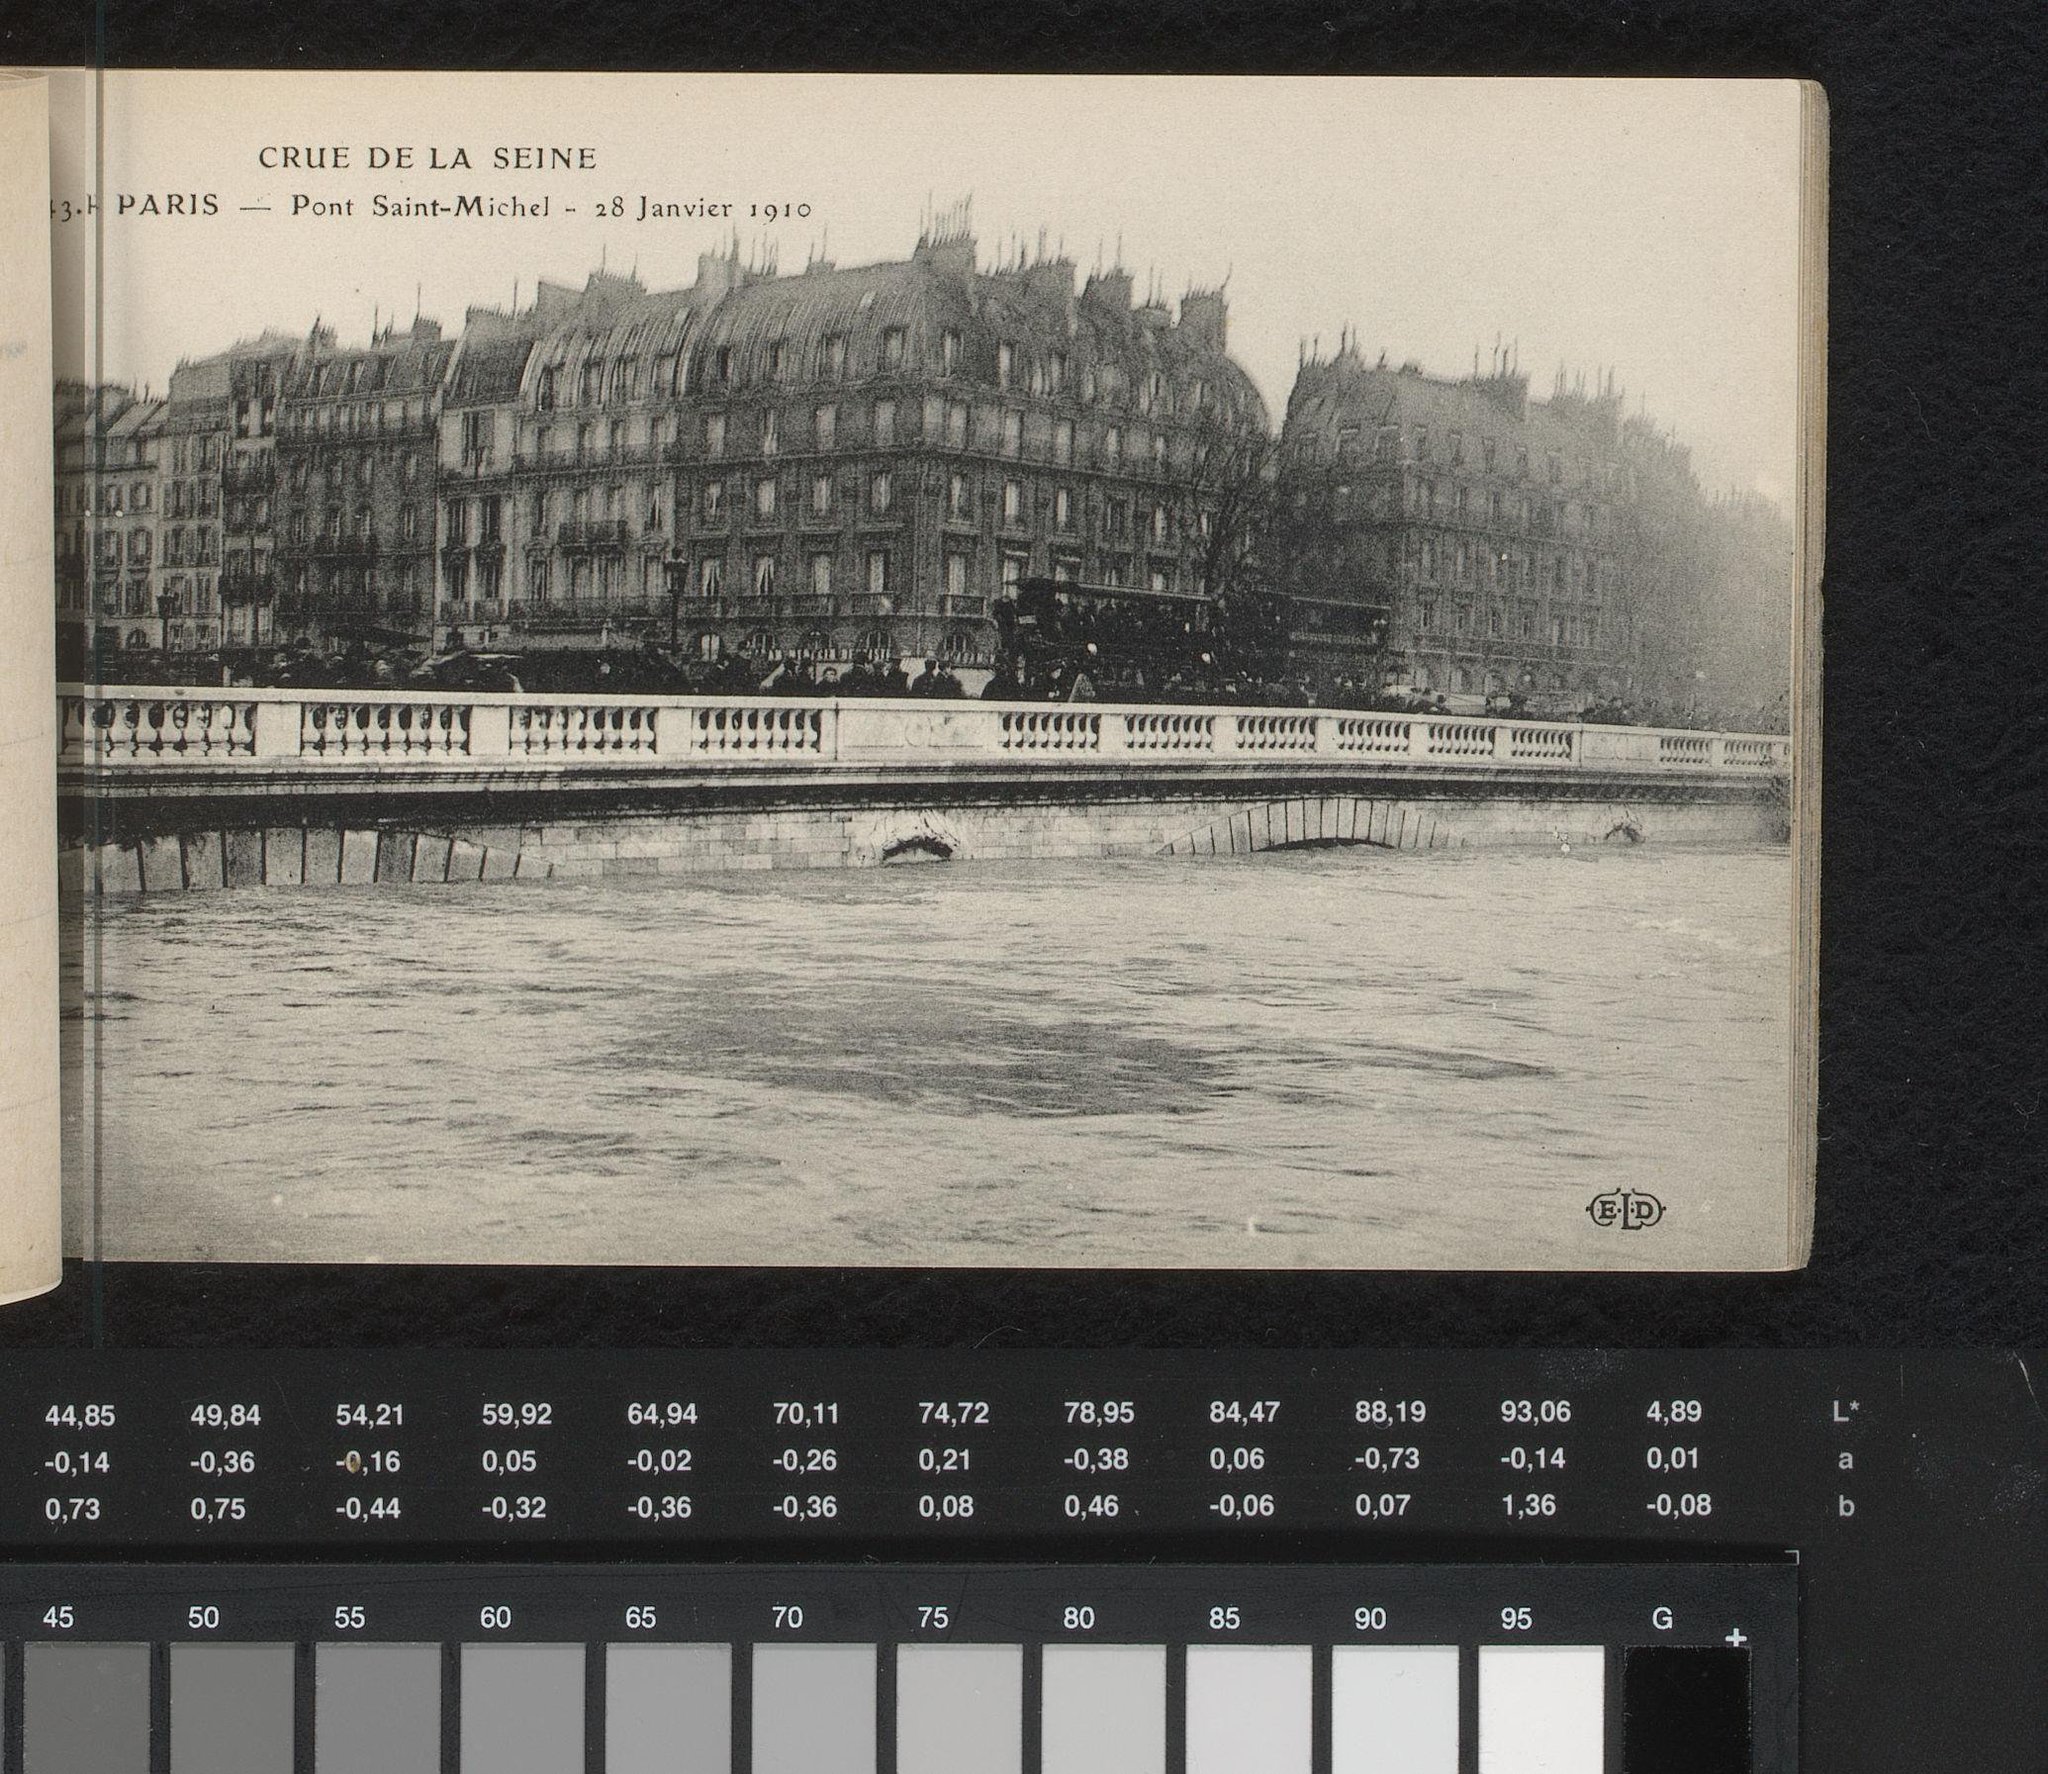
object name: photomechanical print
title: Paris. Pont Saint-Michel. 28 Janvier 1910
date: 1910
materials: cardboard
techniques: photograph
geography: paris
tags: flood, bridge, city-view, and landscape with man-made constructions (+ city(-scape) with figures, staffage)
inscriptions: date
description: Prentbriefkaart maakt deel uit van een album.